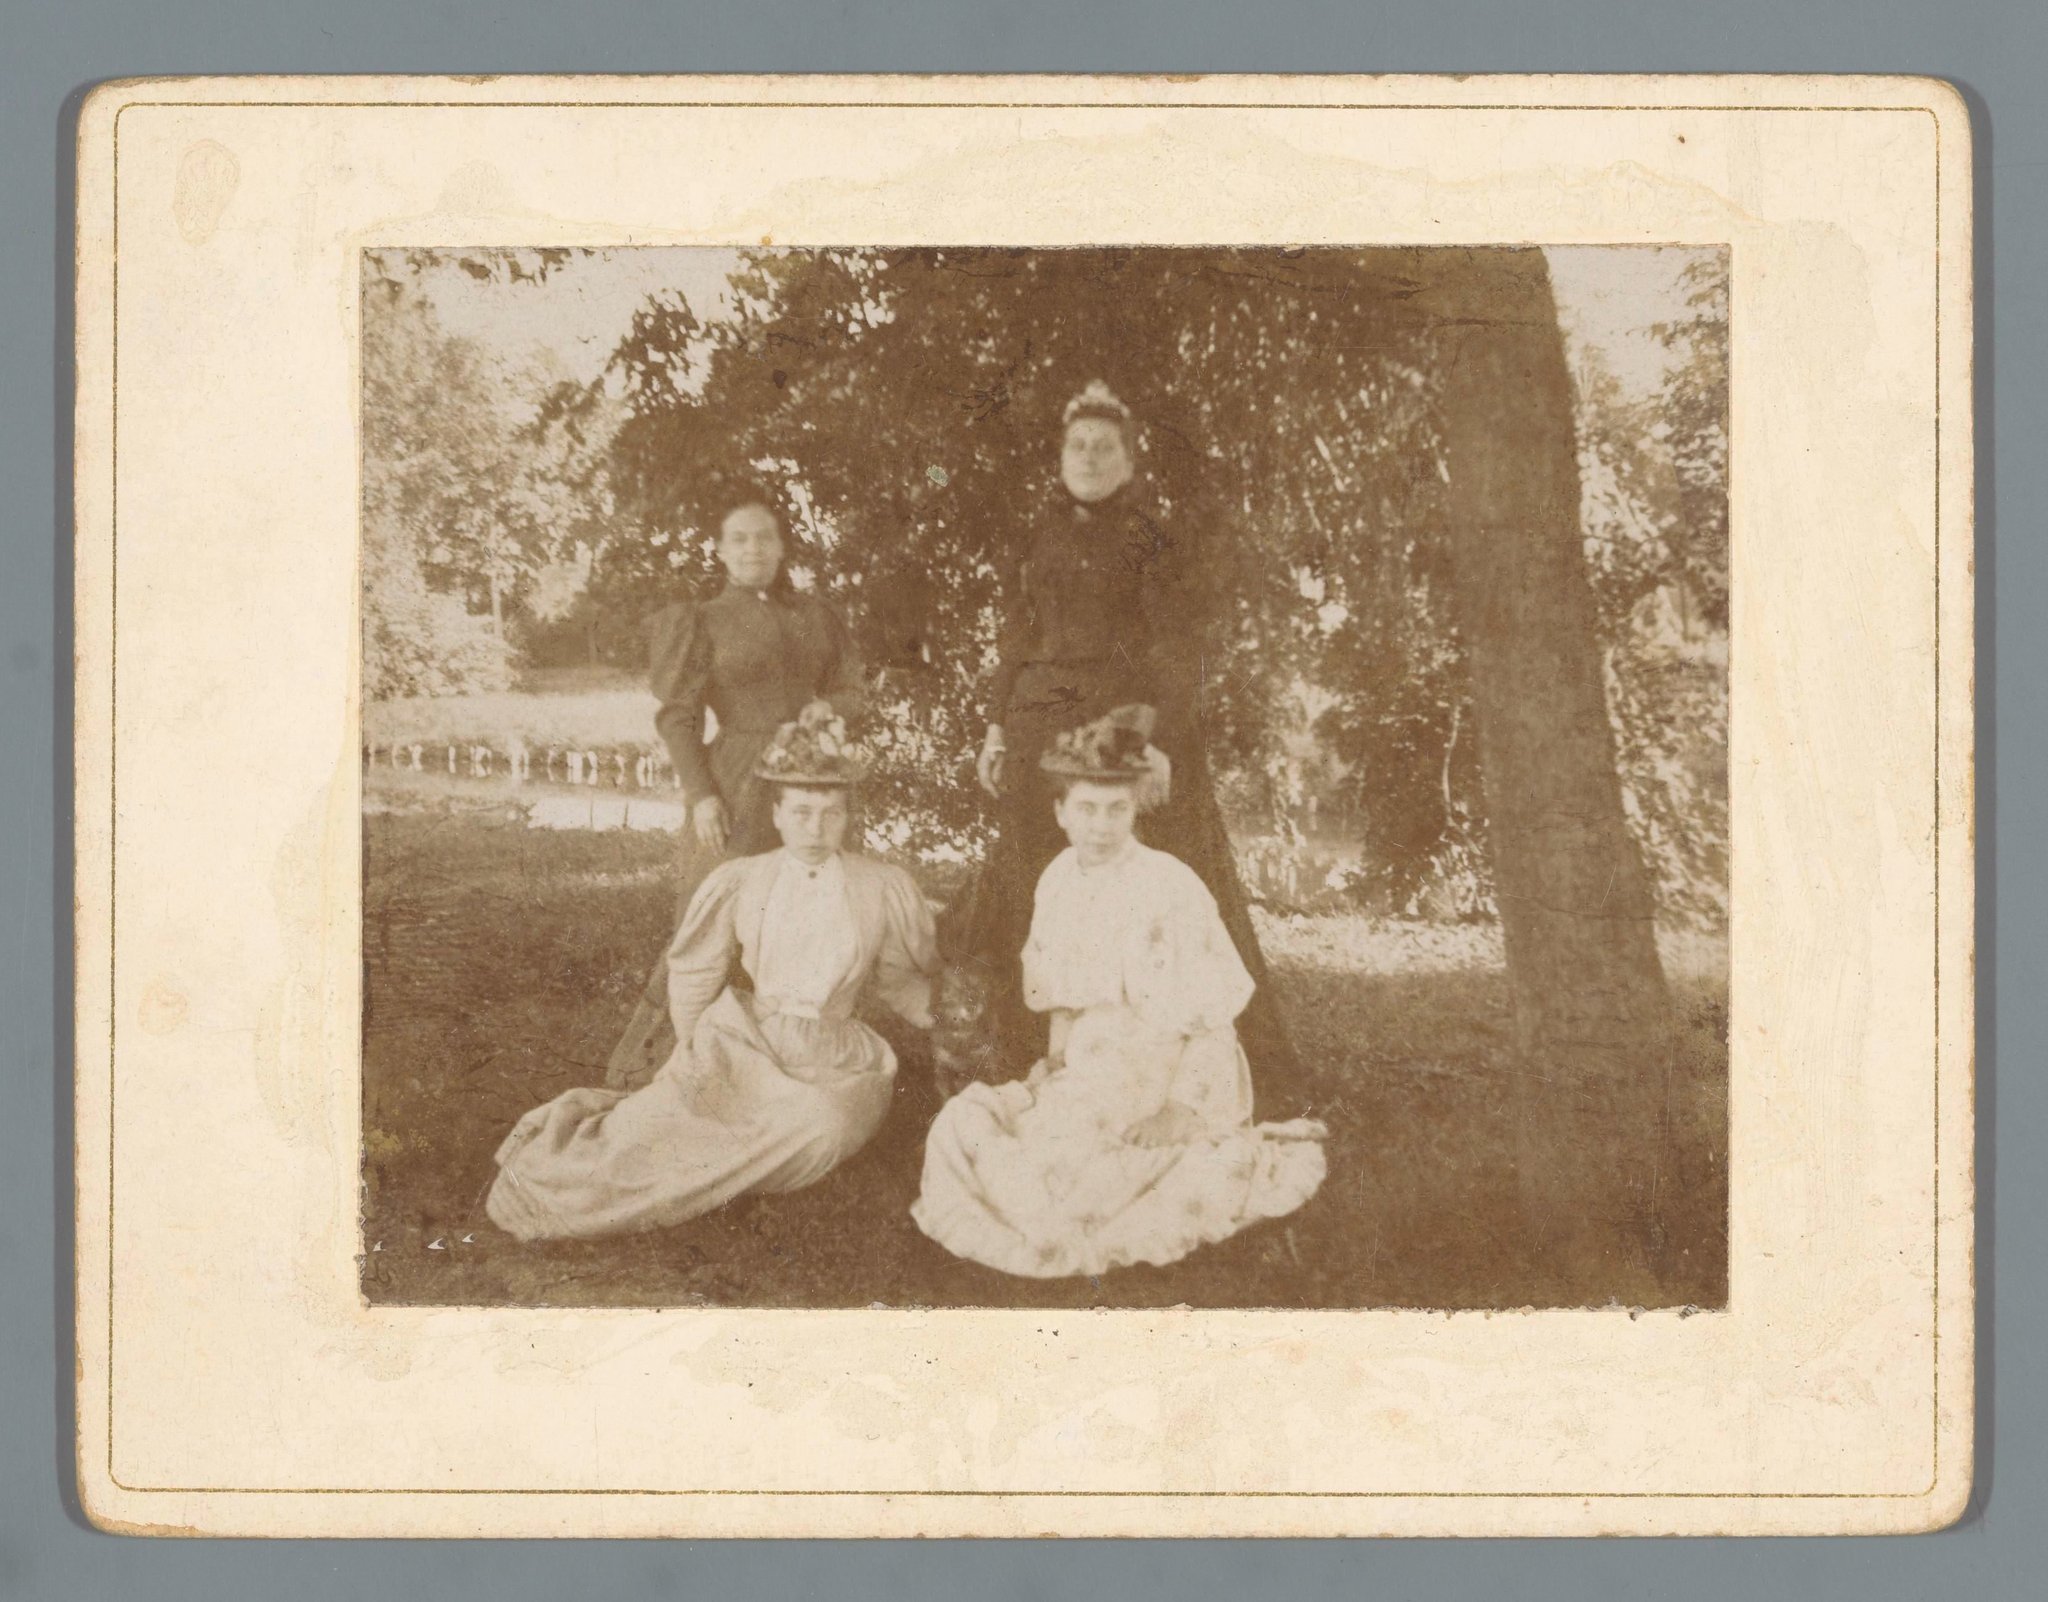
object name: photograph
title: Portret van vier onbekende vrouwen in een park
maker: Anonymous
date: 1900-1915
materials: cardboard, photographic support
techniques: collodion silver print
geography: netherlands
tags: park, adult woman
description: Het gezelschap is ook afgebeeld op RP-F-F20914.